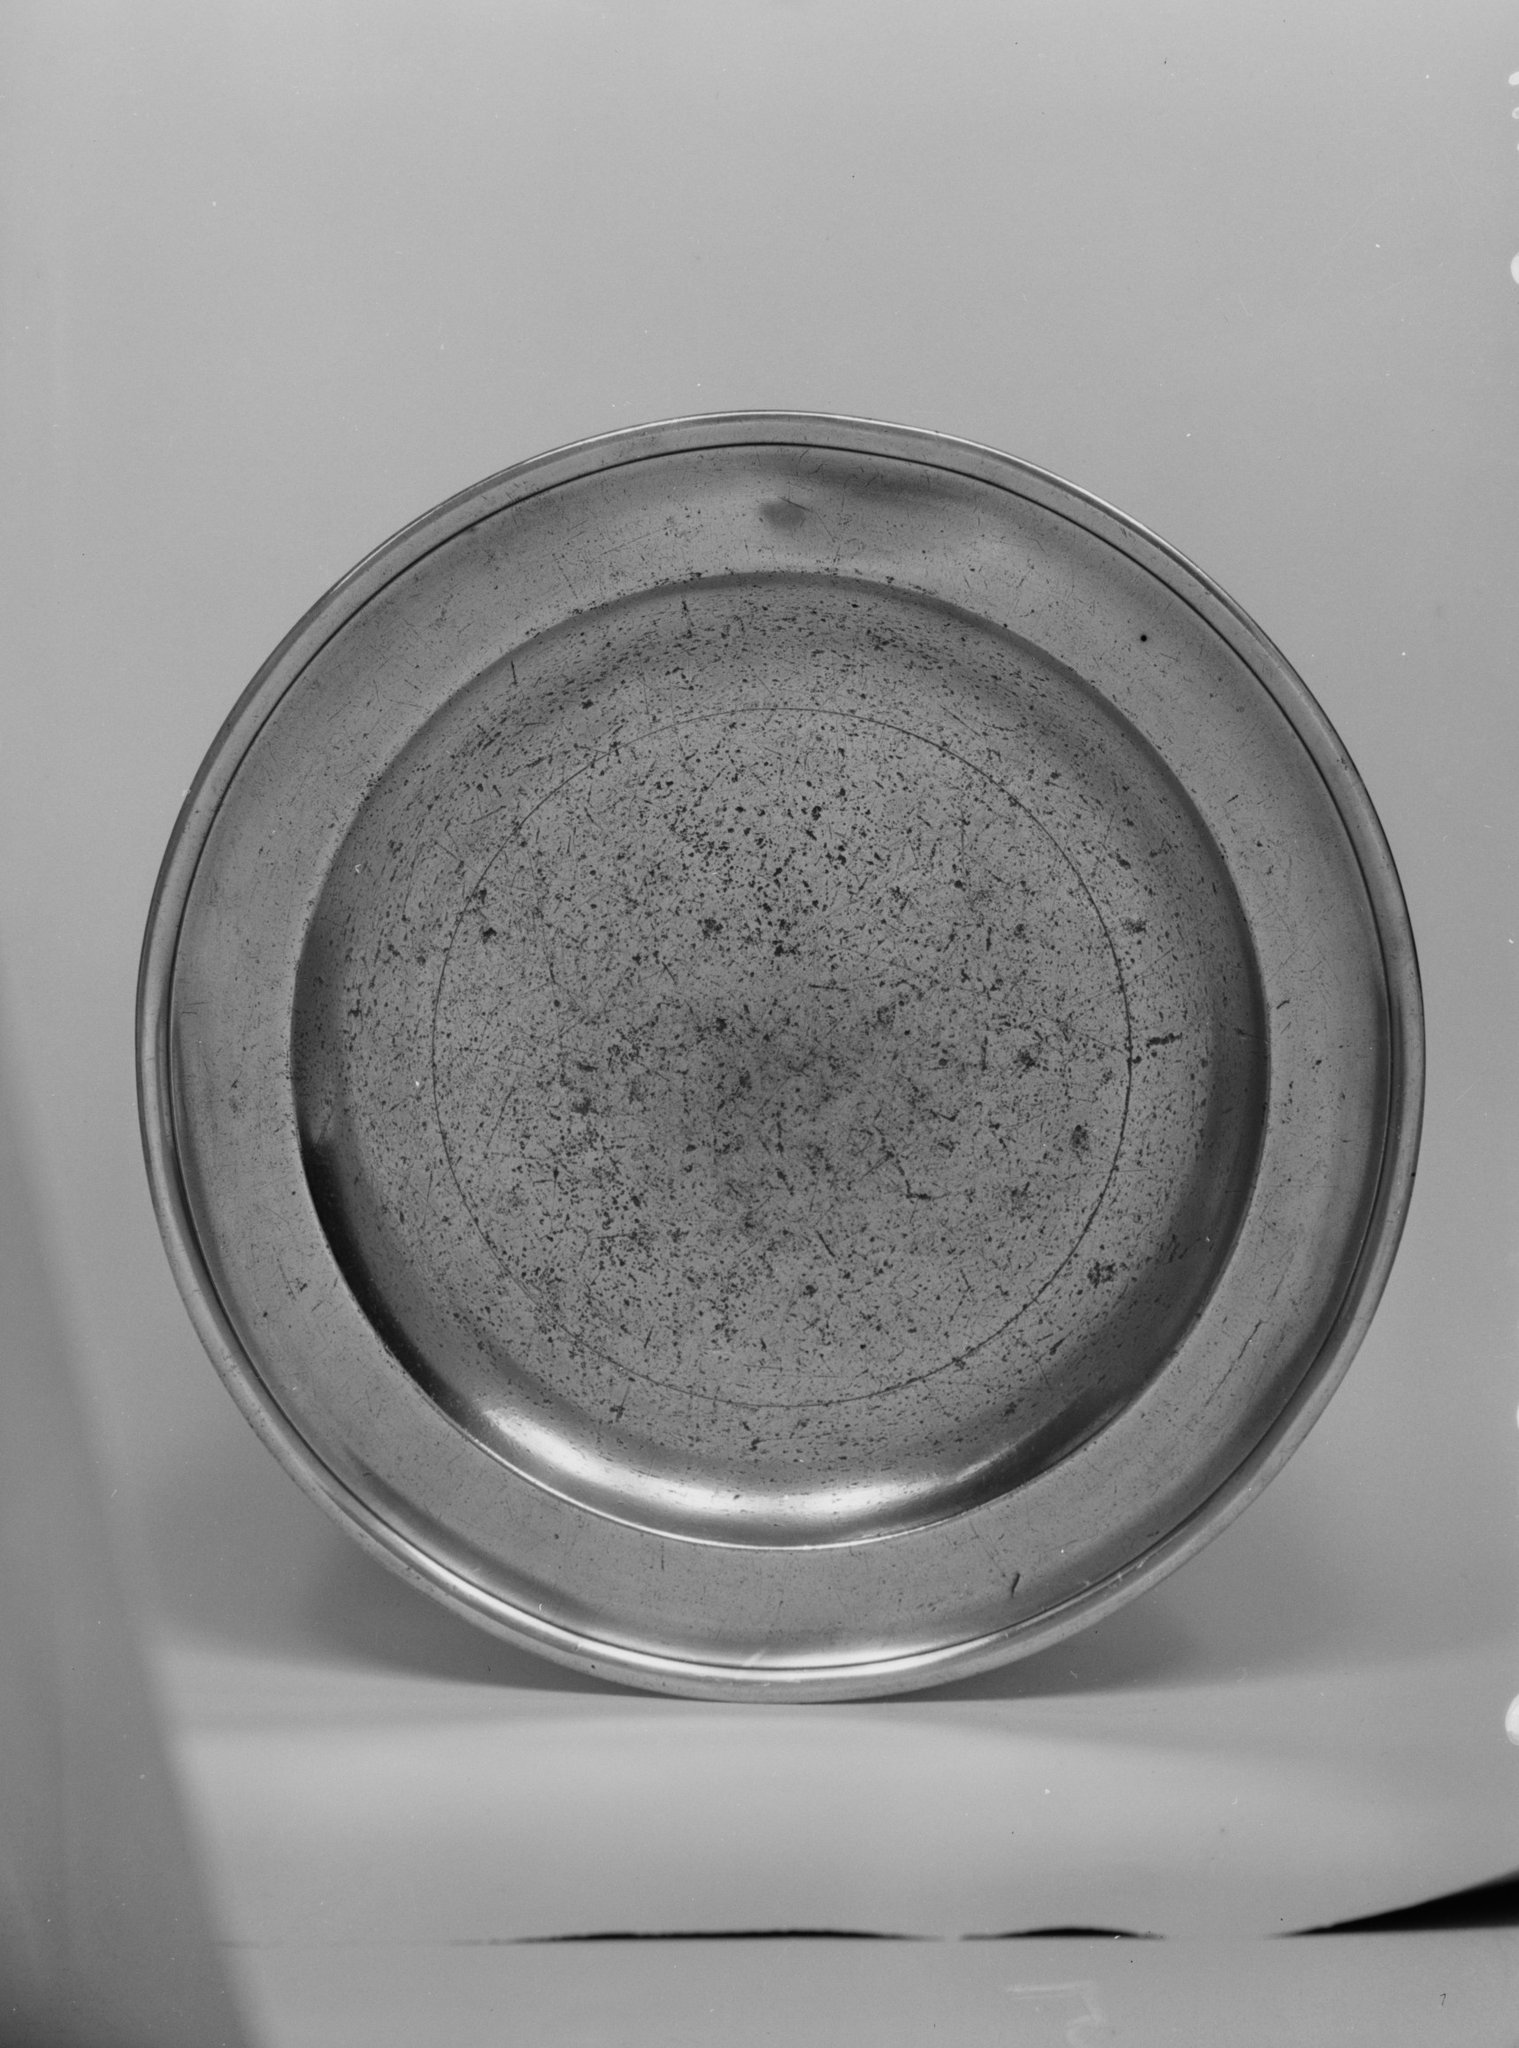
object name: dish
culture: american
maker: frederick bassett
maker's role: maker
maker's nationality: american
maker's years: 1740-1800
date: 1761-1799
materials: pewter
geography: united states